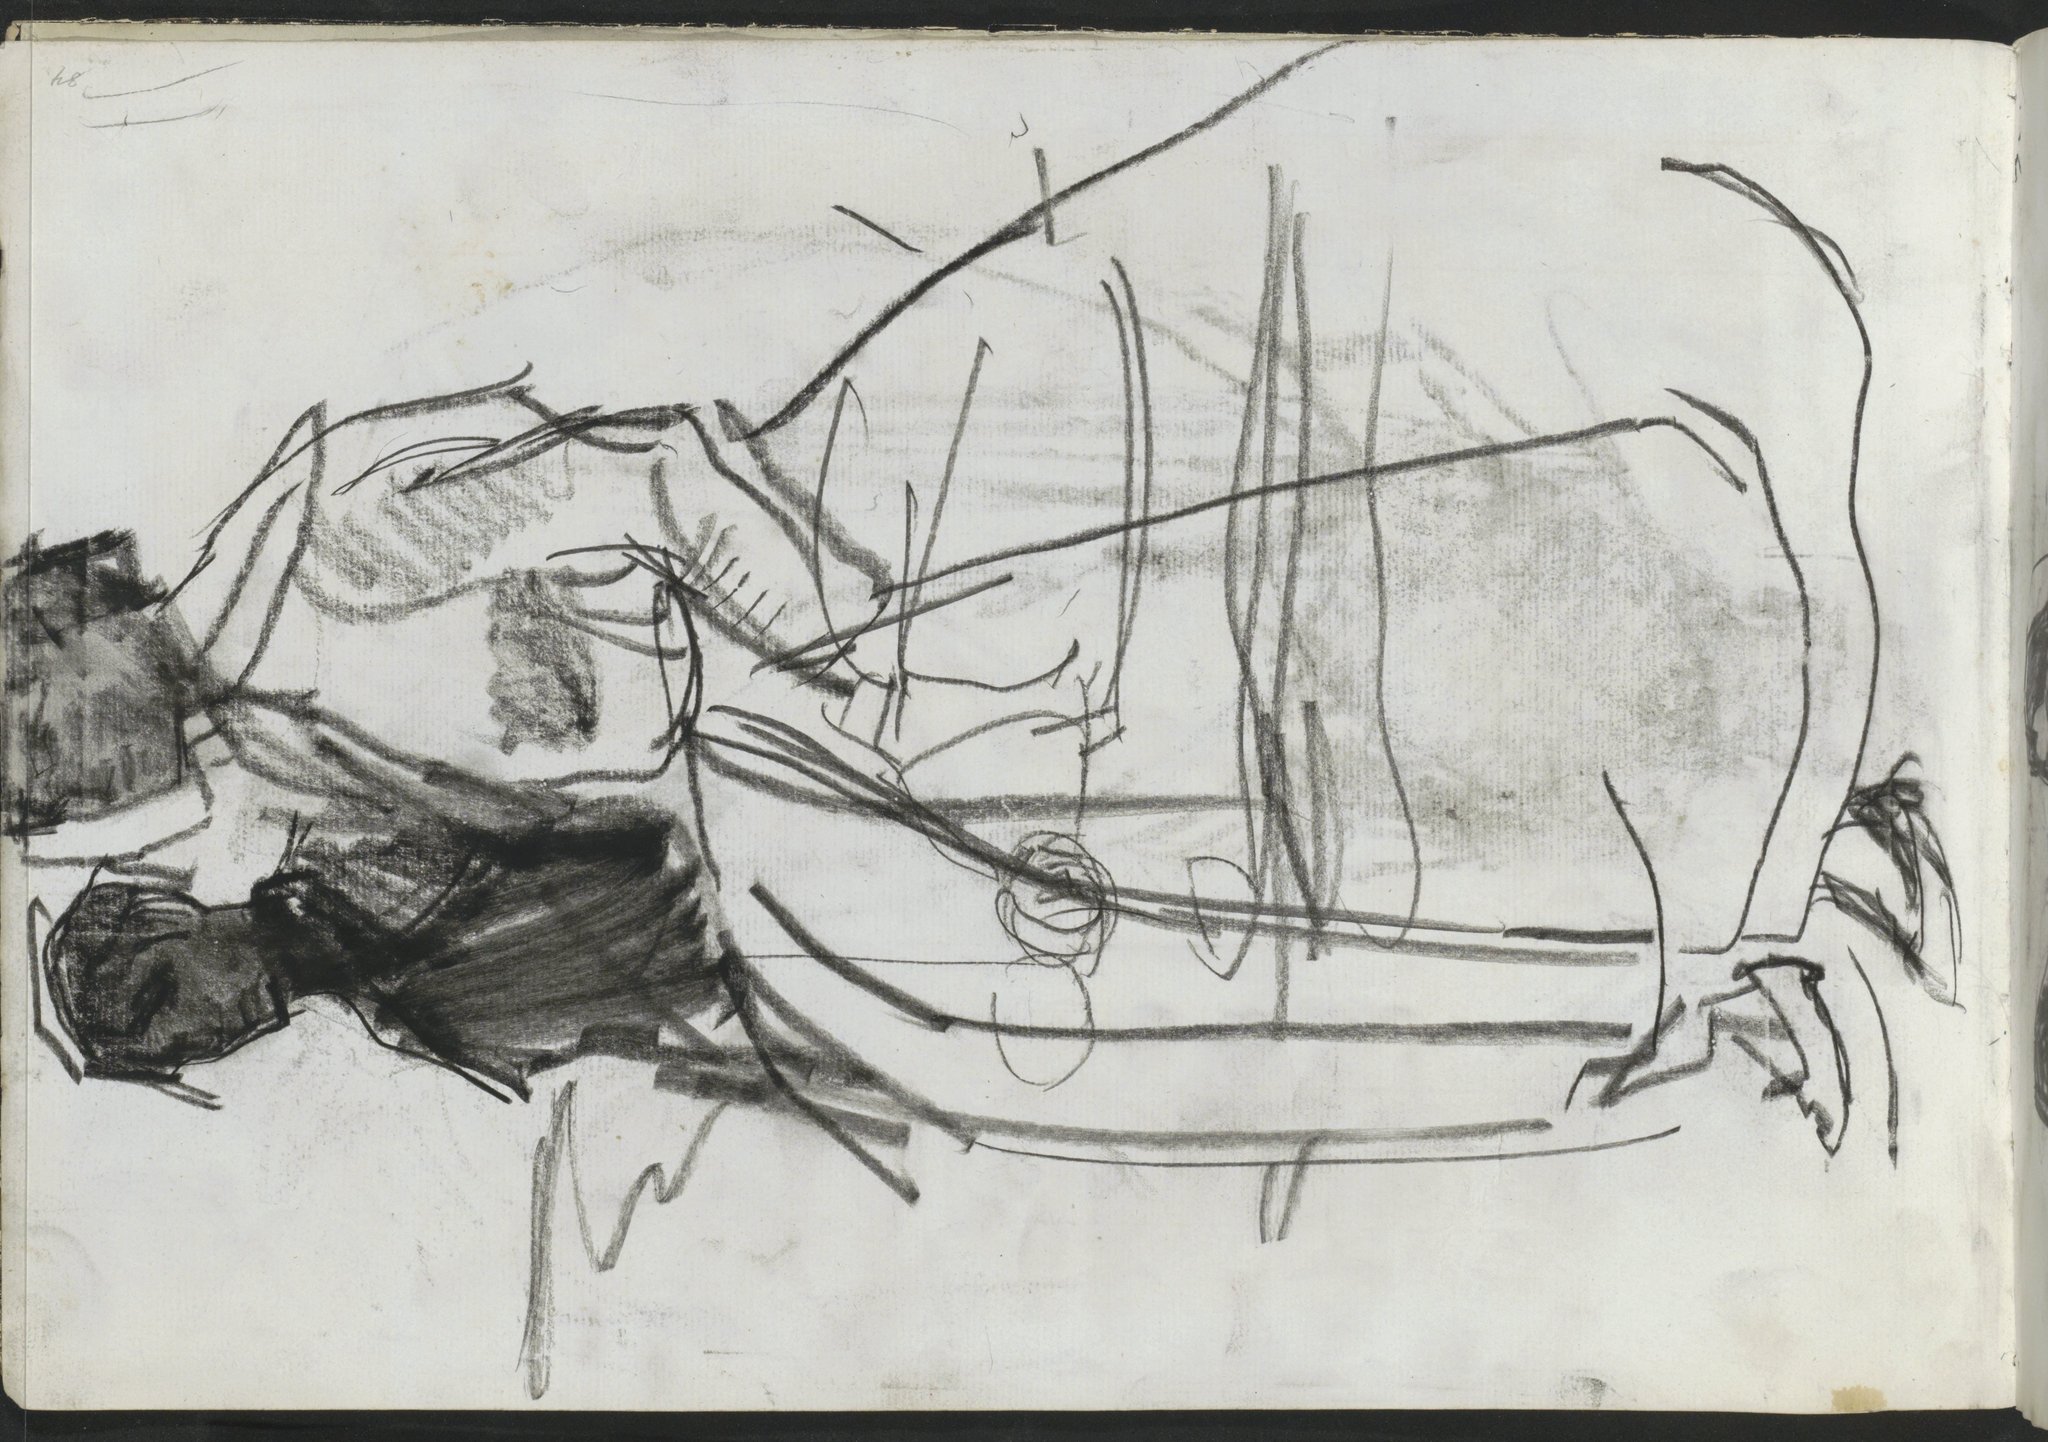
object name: sketchbook leaf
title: Twee vrouwen, mogelijk lopend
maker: isaac israels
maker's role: draughtsman, painter, print maker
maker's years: 1865-1934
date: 1886-1934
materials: charcoal, paper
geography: amsterdam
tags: adult woman (+ standing), walking - aa - female human figure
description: Blad 1 verso uit schetsboek LXX met 17 bladen.